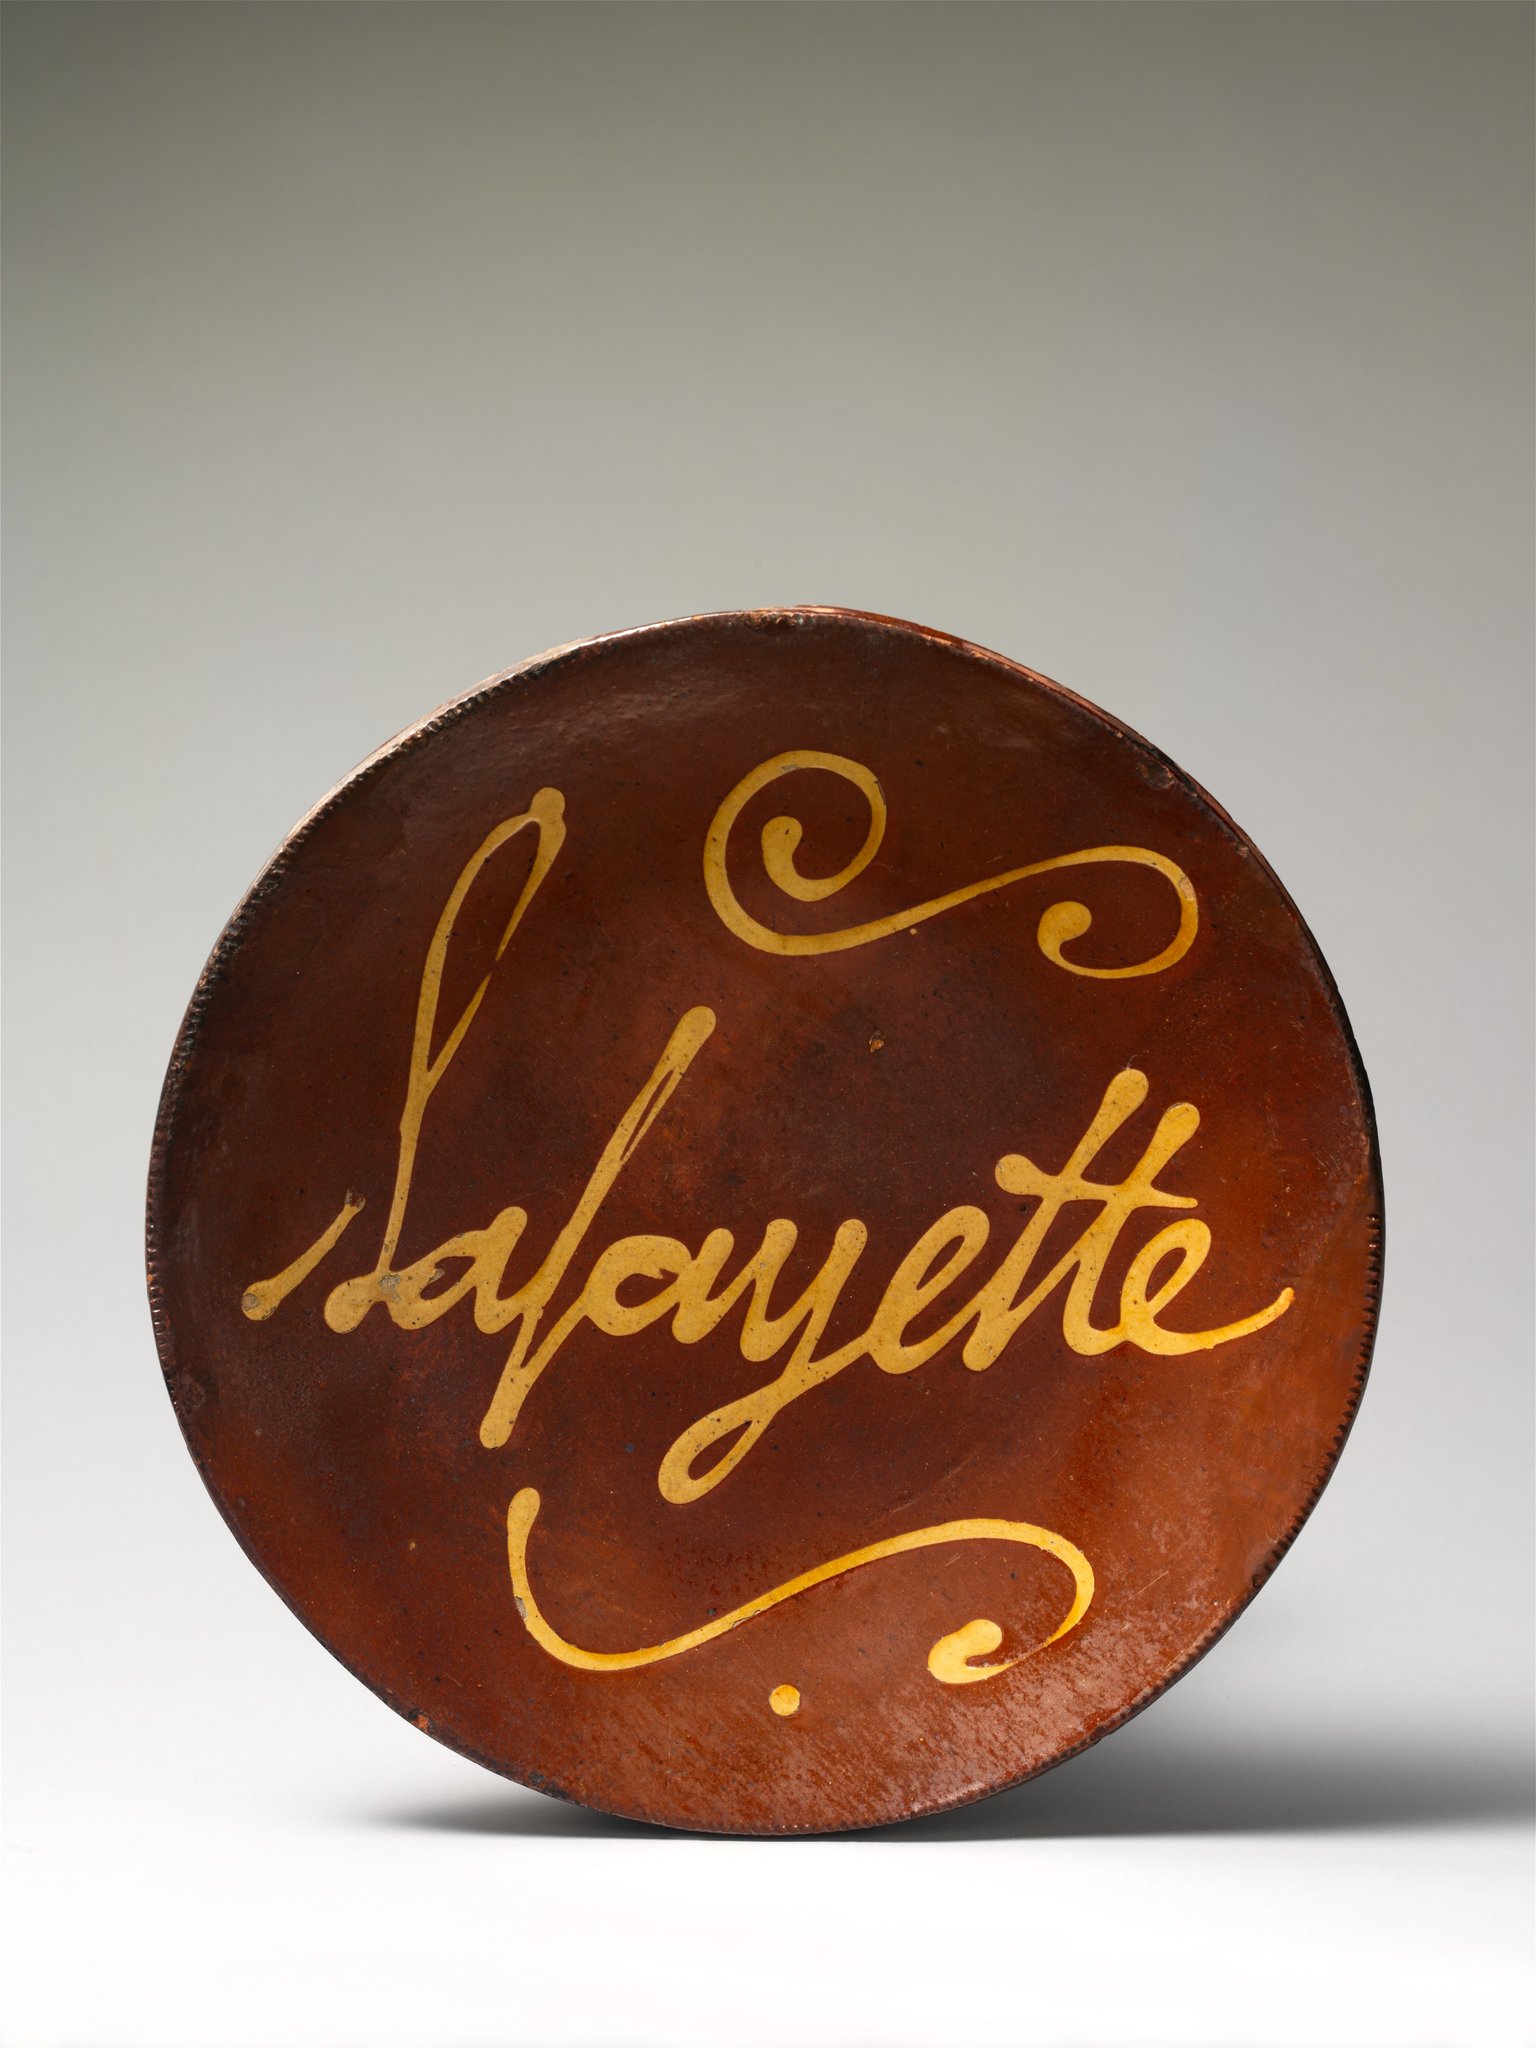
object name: plate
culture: american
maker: asa edward smith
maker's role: maker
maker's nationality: american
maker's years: 1798-1880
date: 1825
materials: earthenware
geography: united states